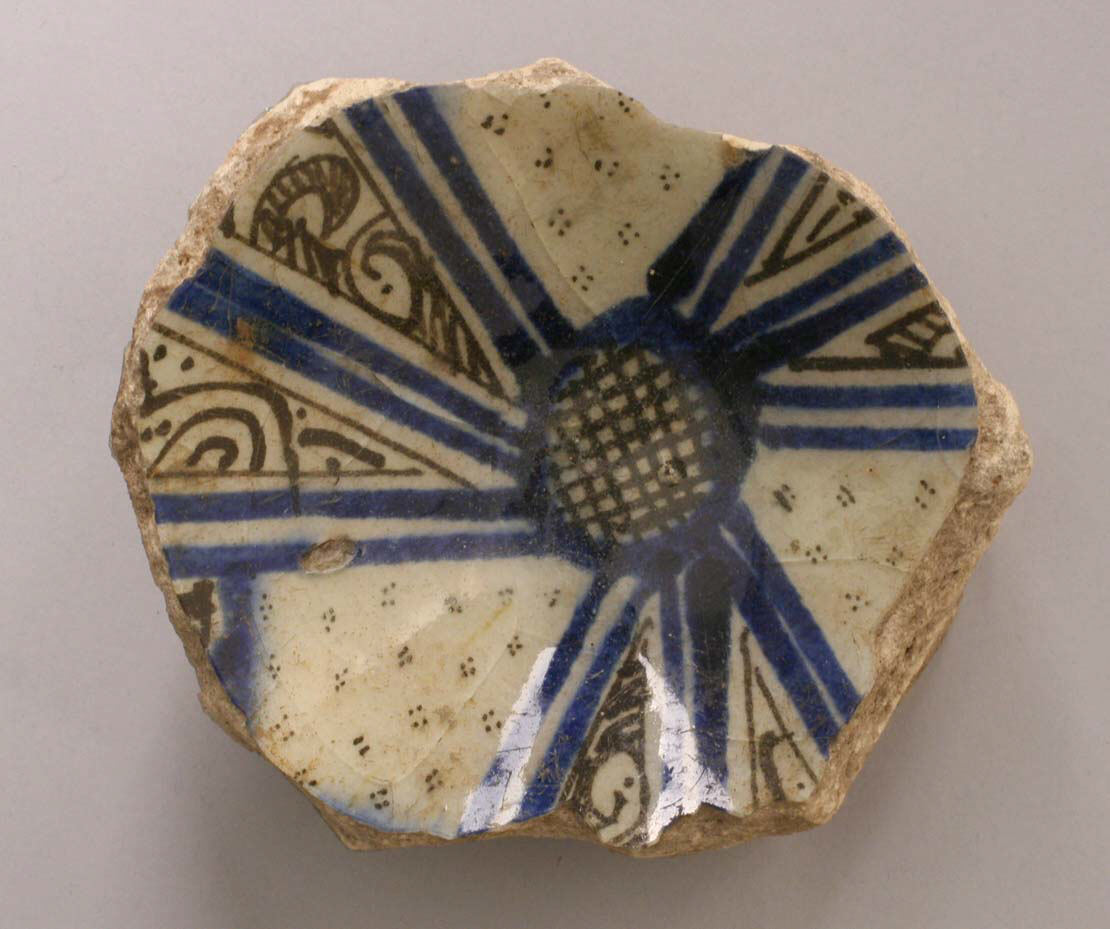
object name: ceramic fragment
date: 1301-1400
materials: glaze, stonepaste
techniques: painting, polychrome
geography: syria